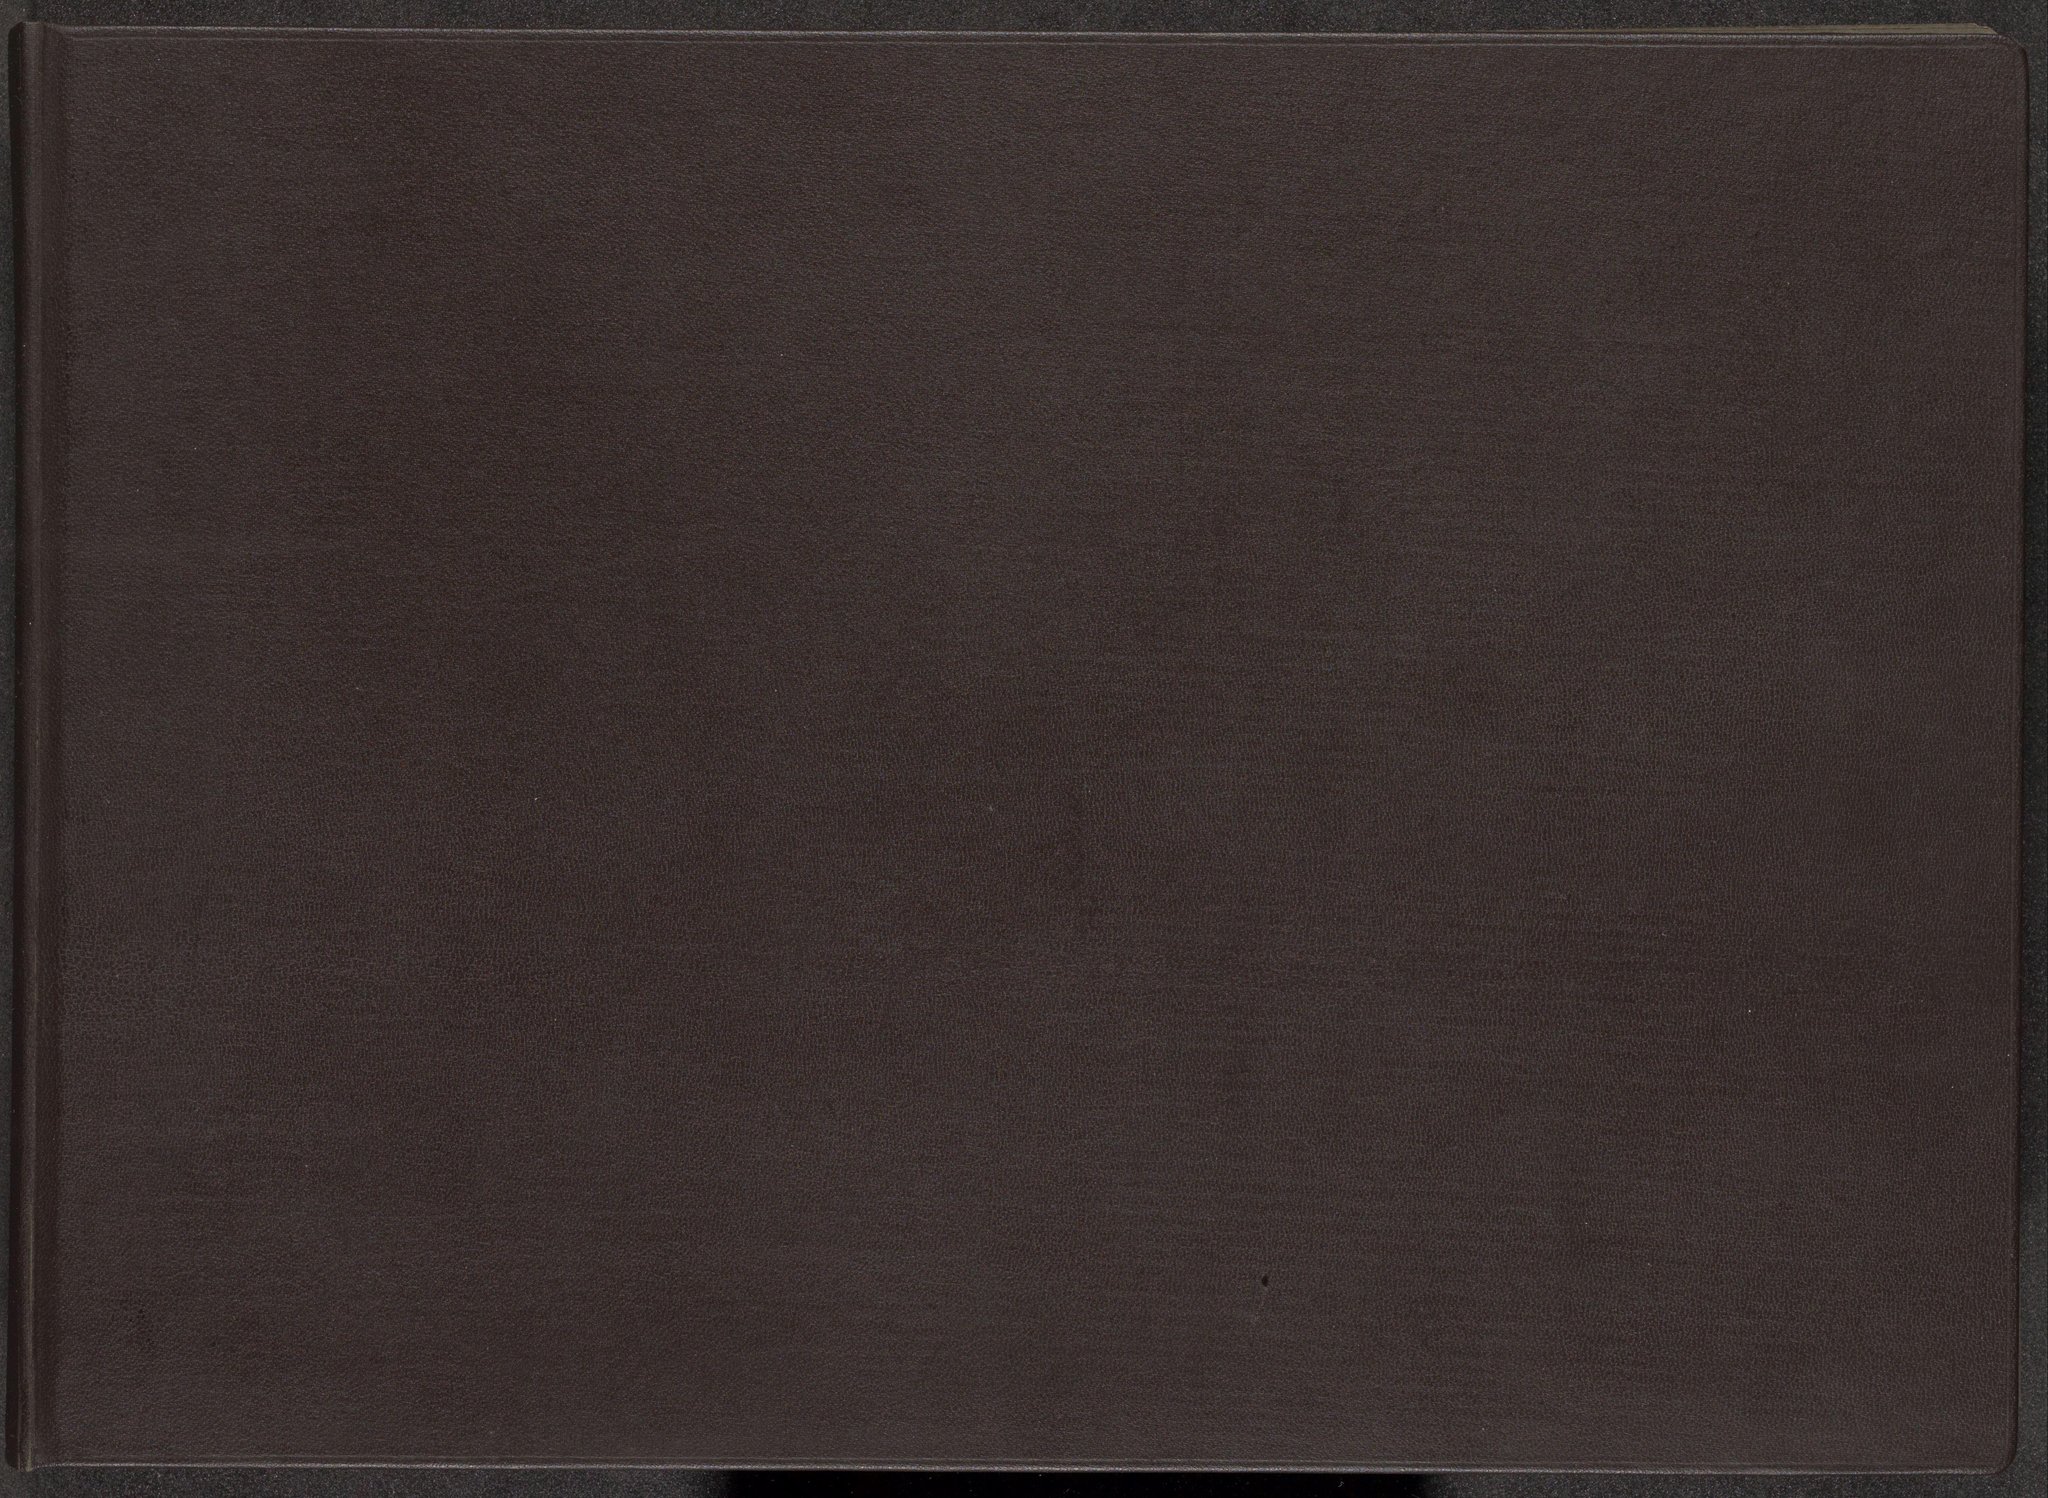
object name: photograph album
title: Fotoalbum van de heer Brams, opperhoutvester van Koningin Wilhelmina op Koninklijke Houtvesterij Het Loo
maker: brams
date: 1900-1920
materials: cardboard, leather, paper, photographic support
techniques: gelatin silver print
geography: het loo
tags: riding a horse, ass, or mule; rider, horseman, hunting, chase, hunting-ground, horse-racing, race-track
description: Fotoalbum in bruine leren band met 26 kartonnen bladen en 281 ingeplakte foto's. De randen van de bladen lijken afgesneden te zijn en opnieuw ingebonden. Bijna alle bladen hebben een vergelijkbare indeling: rondom een kleine ronde, ruitvormige of uitgeknipte afdruk zijn vier grotere foto's geplakt. Het album behoorde toe aan de heer Brams, de opperhoutvester die aan het hoofd stond van de Koninklijke Houtvesterij Het Loo ten tijde van het koningschap van Wilhelmina en belast was met het beheer van het koninklijk bezit. Het album toont ruitertaferelen op en rond de houtvesterij: ruiters, paarden, jachthonden, bossen, heidevelden, landwegen, boerderijen en landhuizen. Veelvuldig zijn de momenten in beeld gebracht waarbij een ruitergezelschap afstijgt en in de vrije natuur geniet van een hapje en een drankje. Ook zijn er meerdere opnames van vierspanrijden en van steeplechaseraces (hindernisraces) op een niet-geïdentificeerde renbaan.